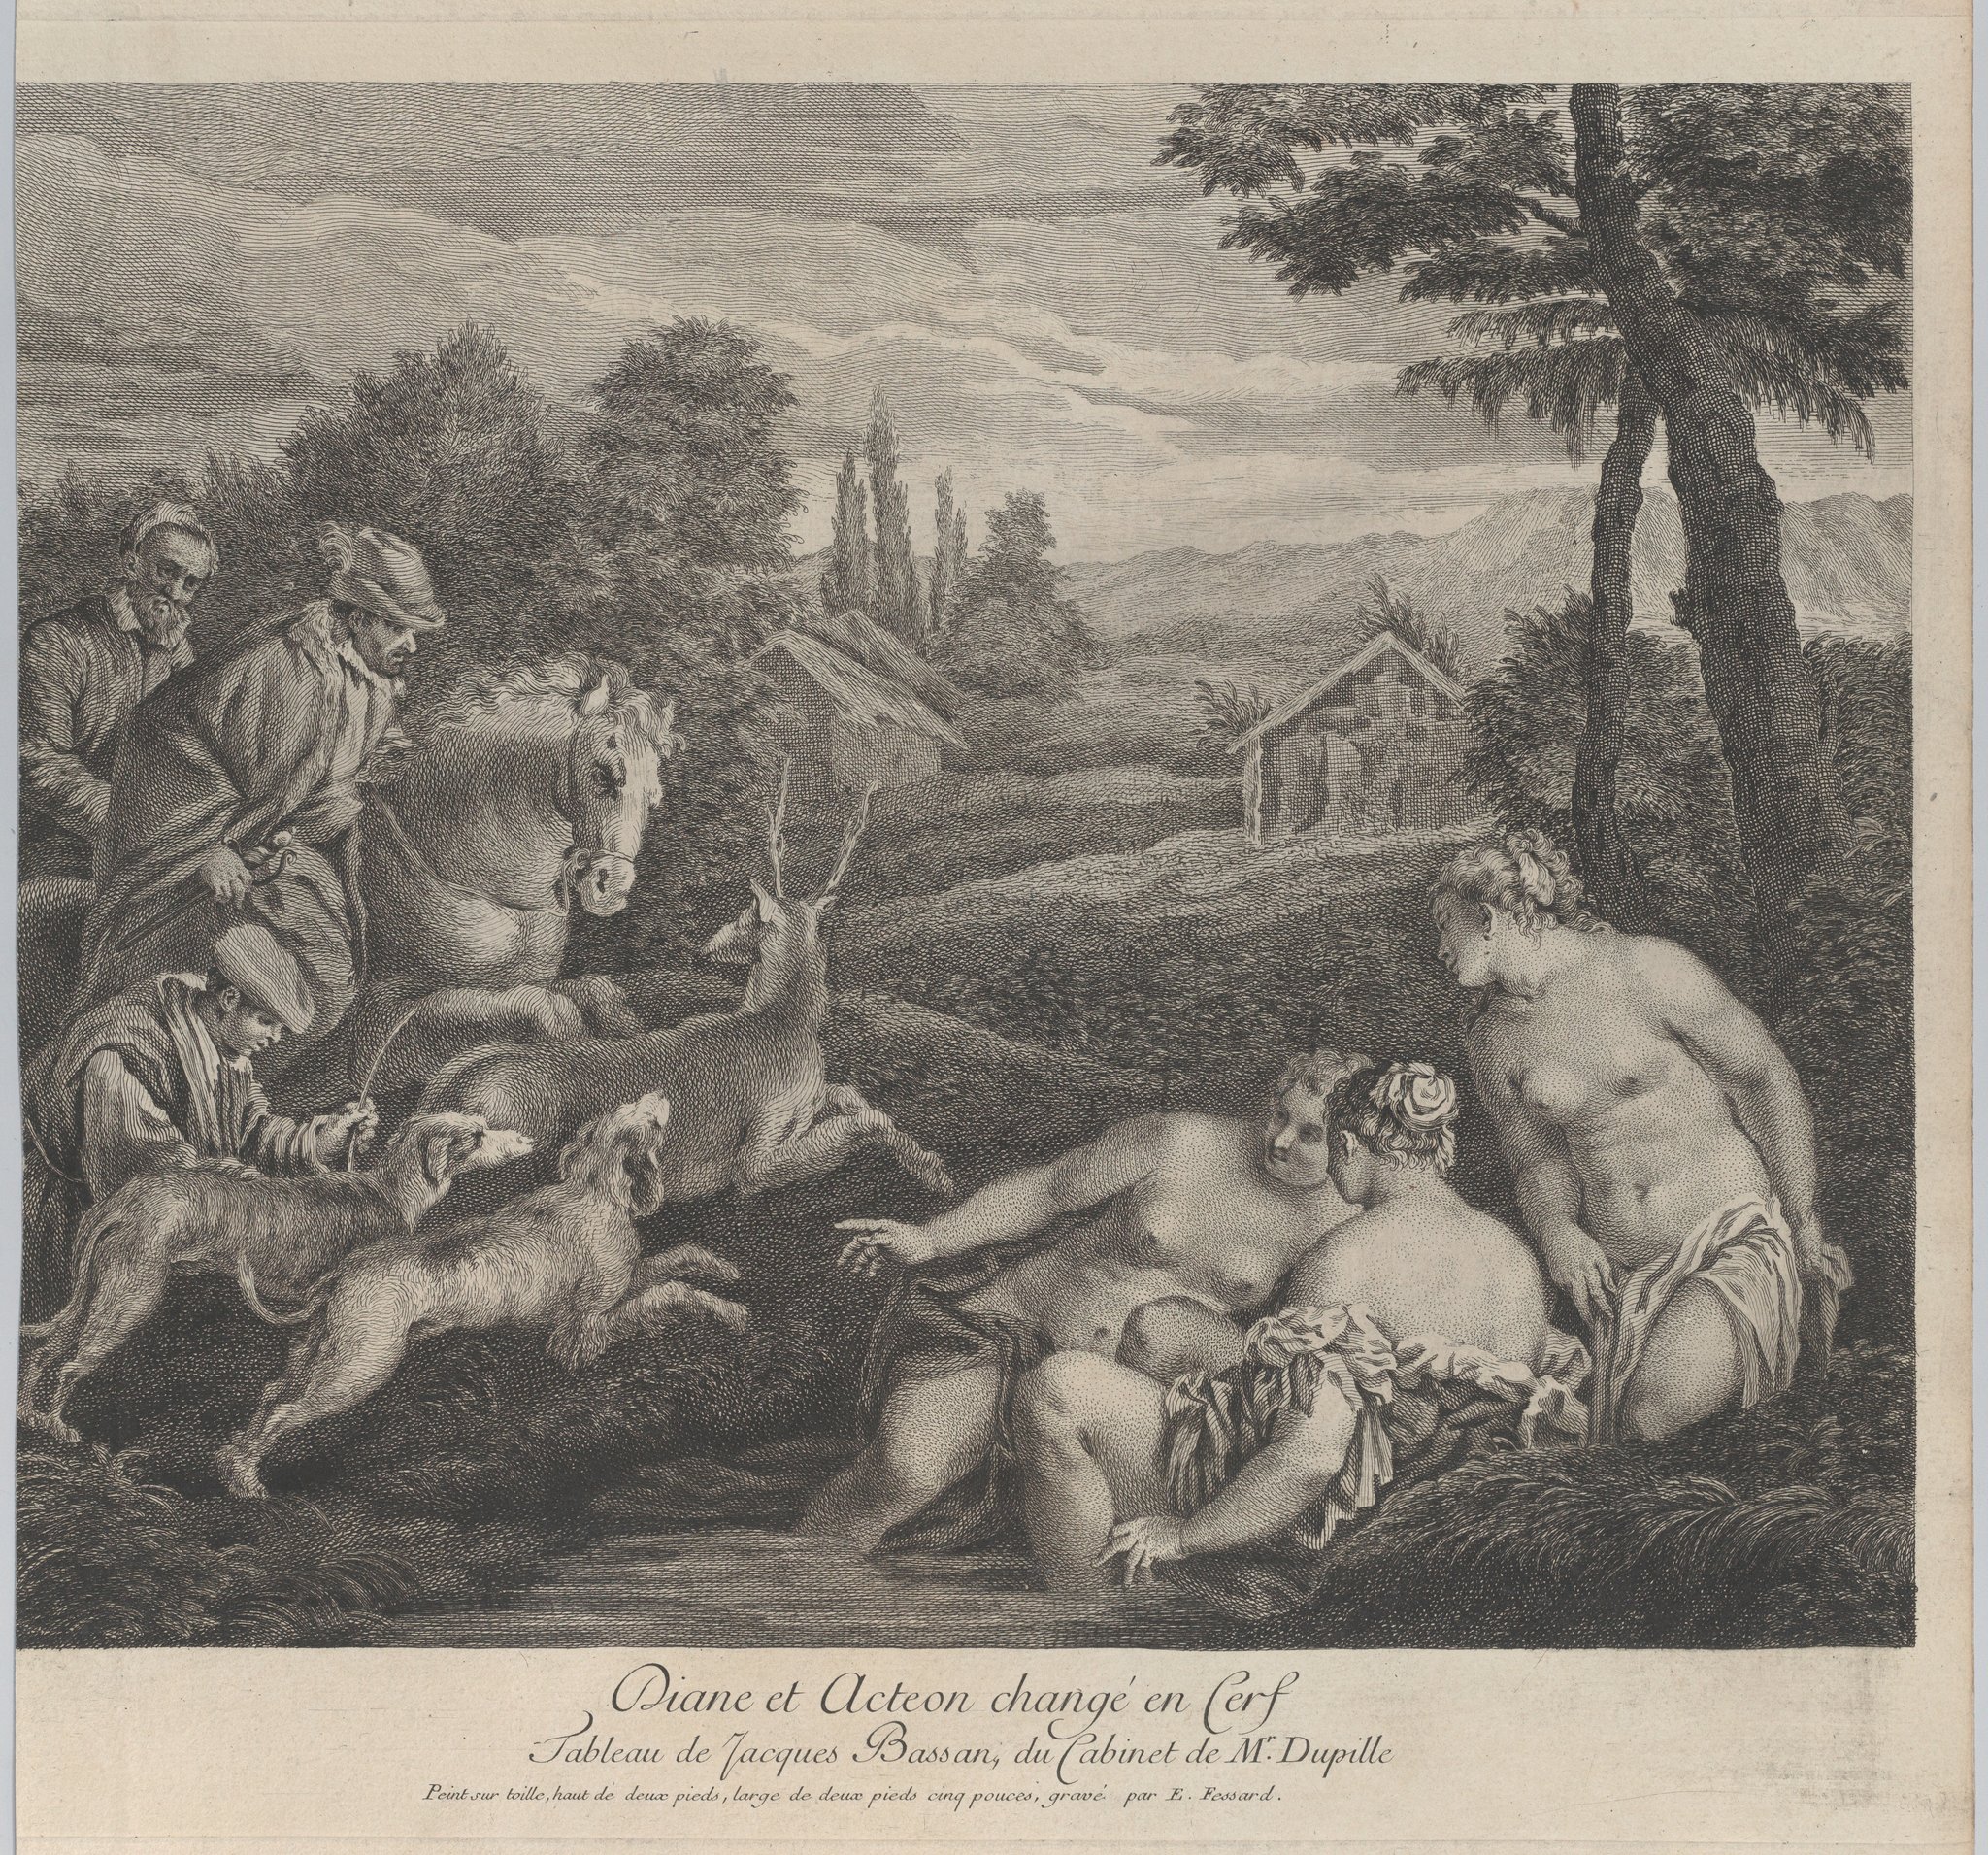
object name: print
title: Diana and Acteon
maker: etienne fessard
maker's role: artist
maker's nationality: french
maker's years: 1714-1777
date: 1742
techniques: etching